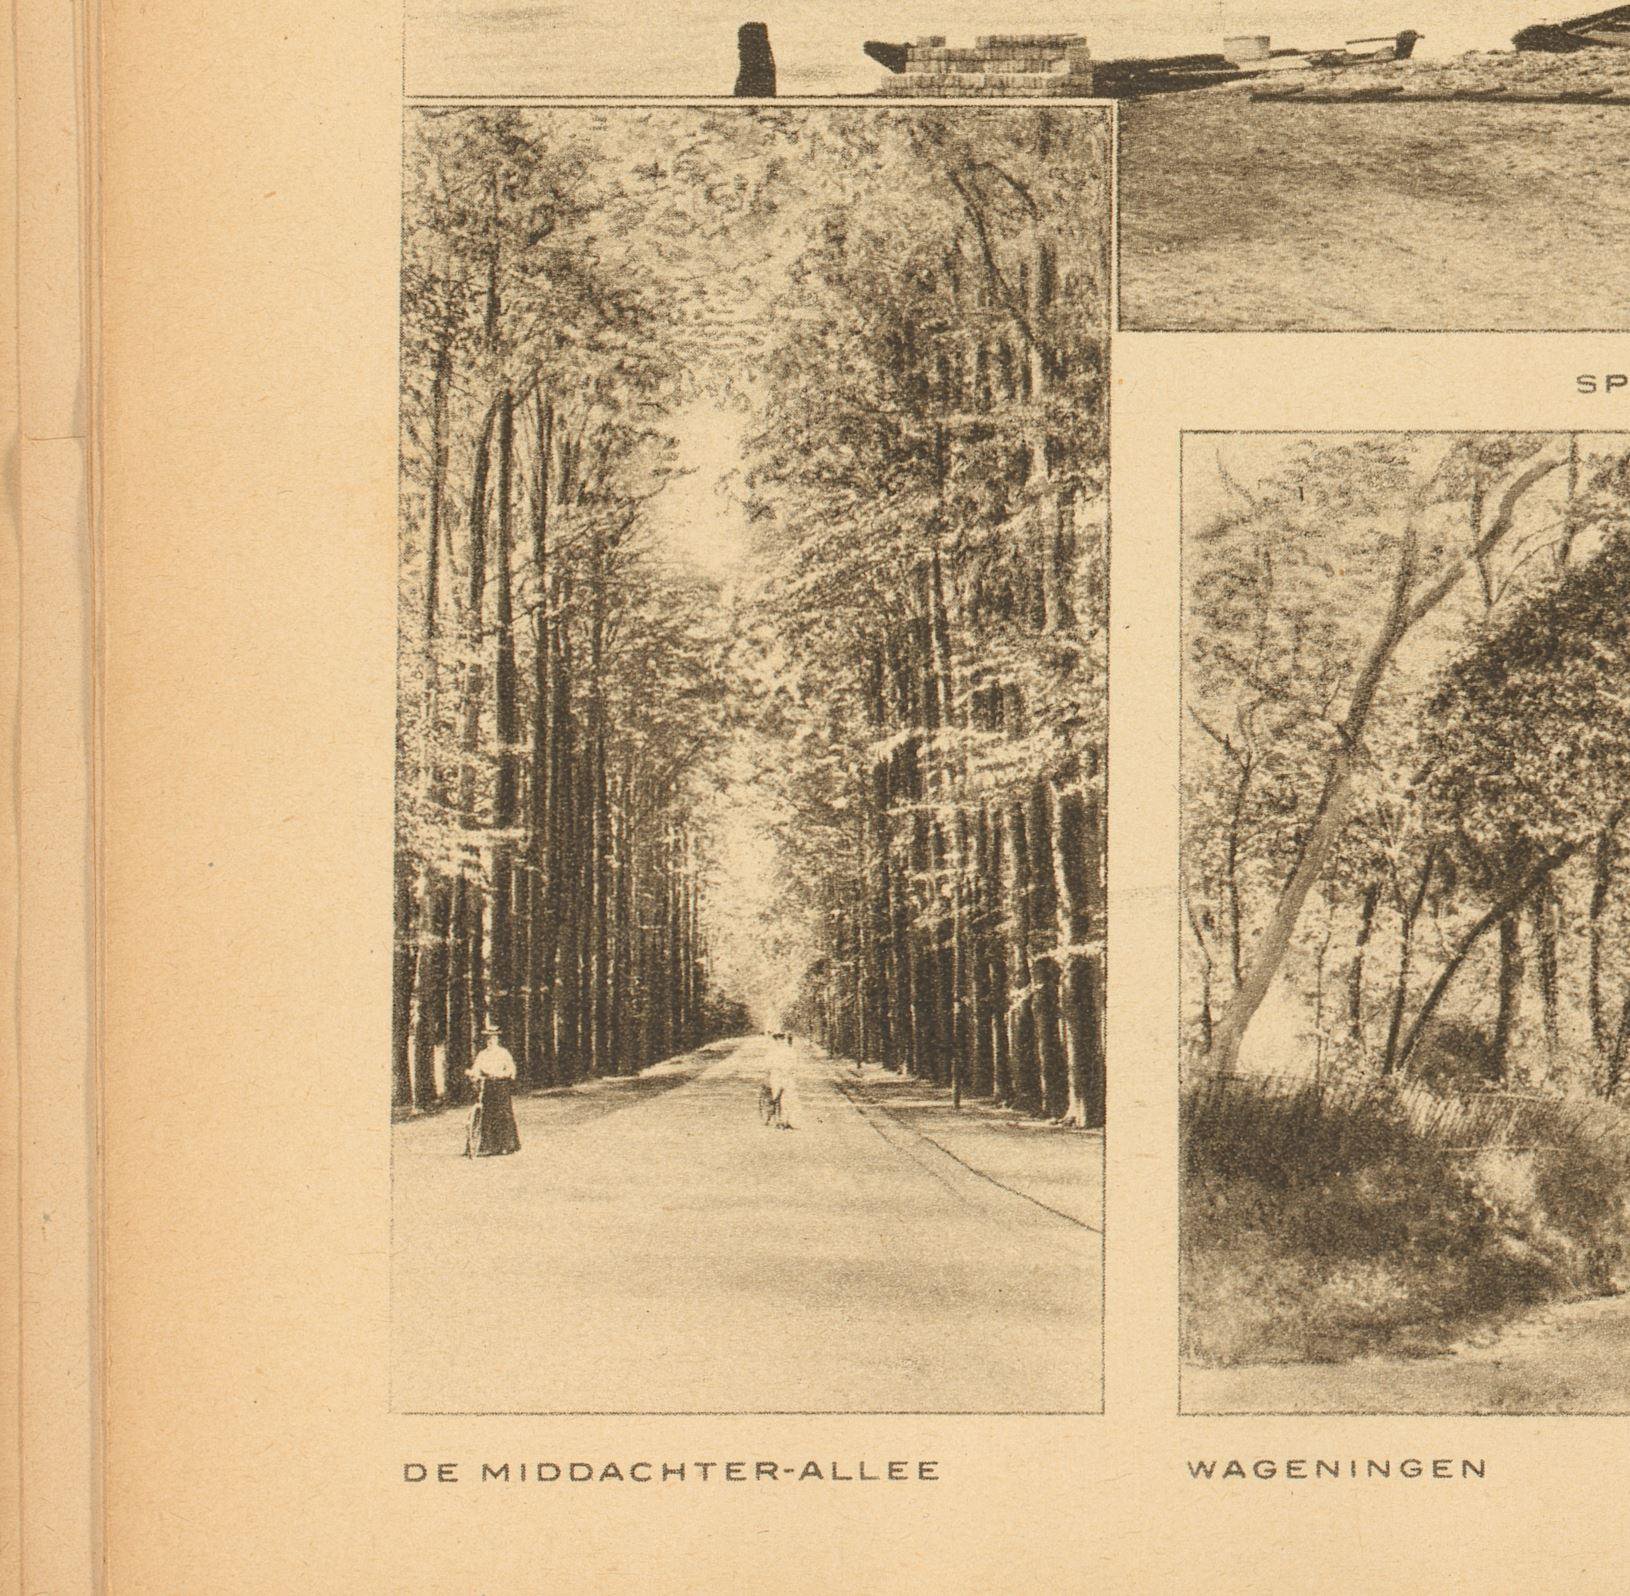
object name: album leaf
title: De Middachter-allee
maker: Anonymous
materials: paper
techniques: rotogravure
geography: leiden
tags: lane, alley, gelderland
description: Deze prent maakt deel uit van een album.